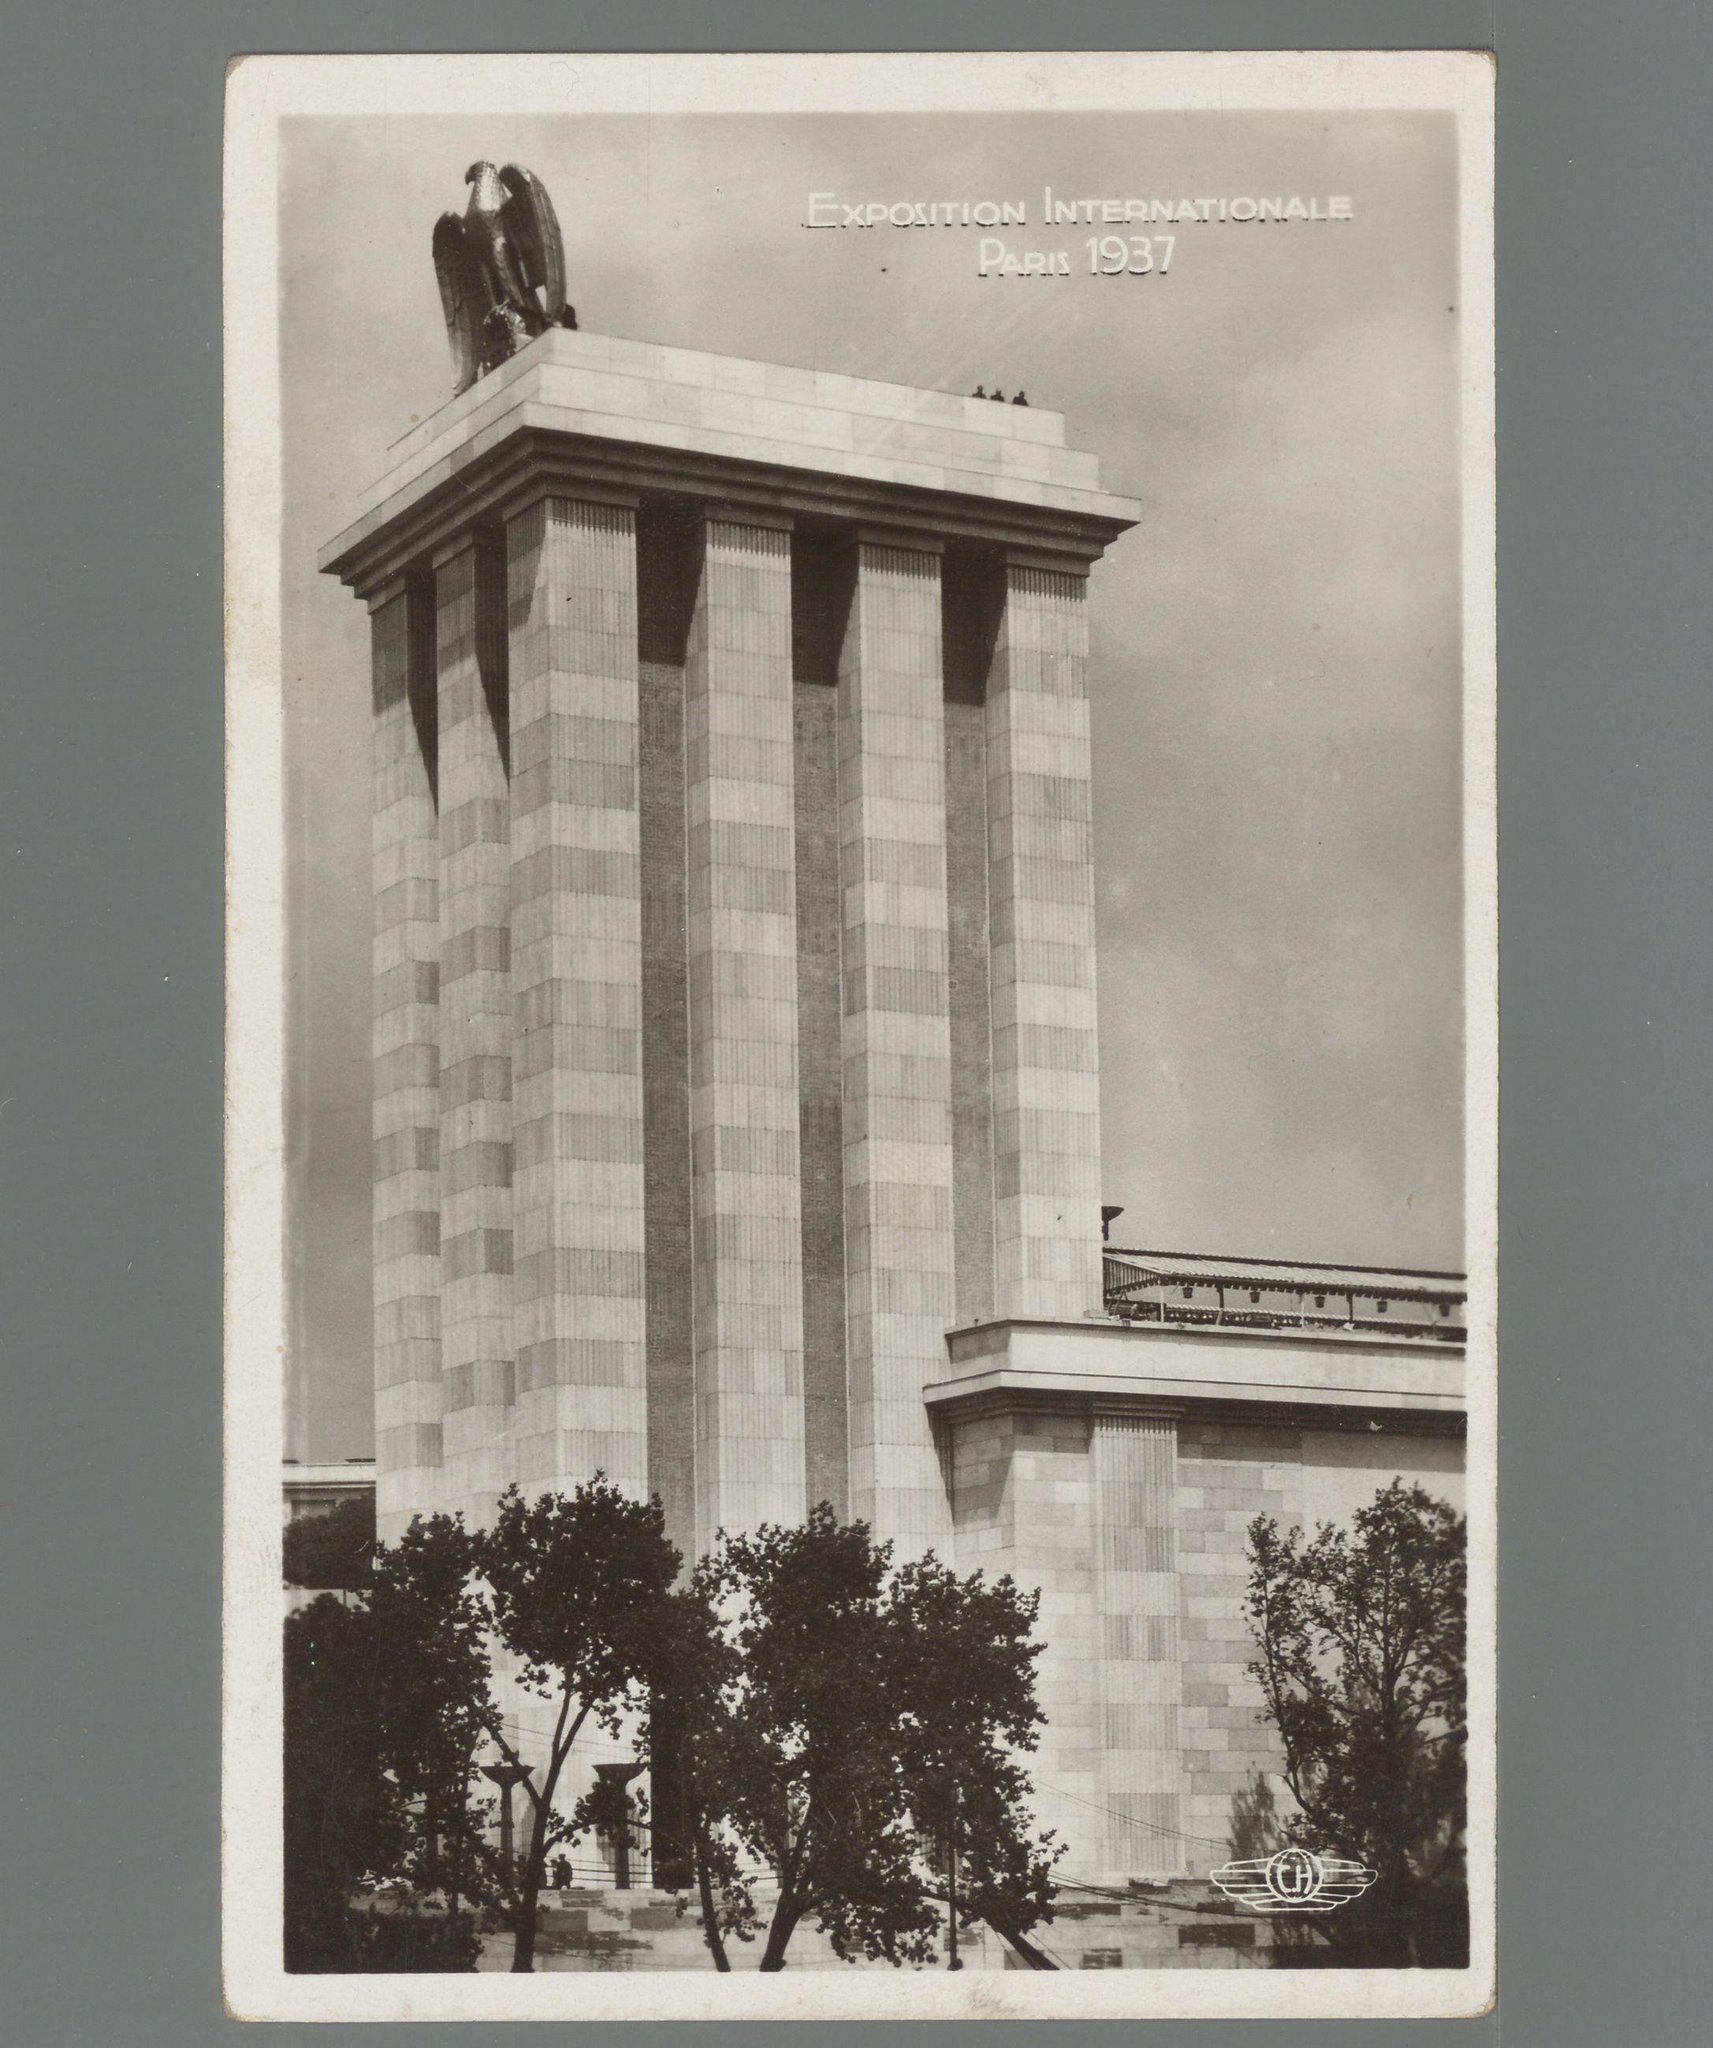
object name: photograph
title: Exposition Internationale Paris 1937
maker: h. chipault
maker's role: publisher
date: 1937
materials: photographic support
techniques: photography, writing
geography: boulogne-sur-seine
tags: temporary exhibition, 'salon', paris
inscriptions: postage stamp